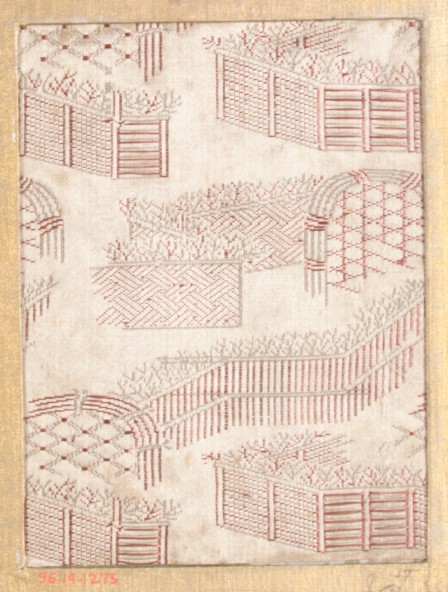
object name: piece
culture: japanese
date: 1701-1900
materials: silk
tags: fences